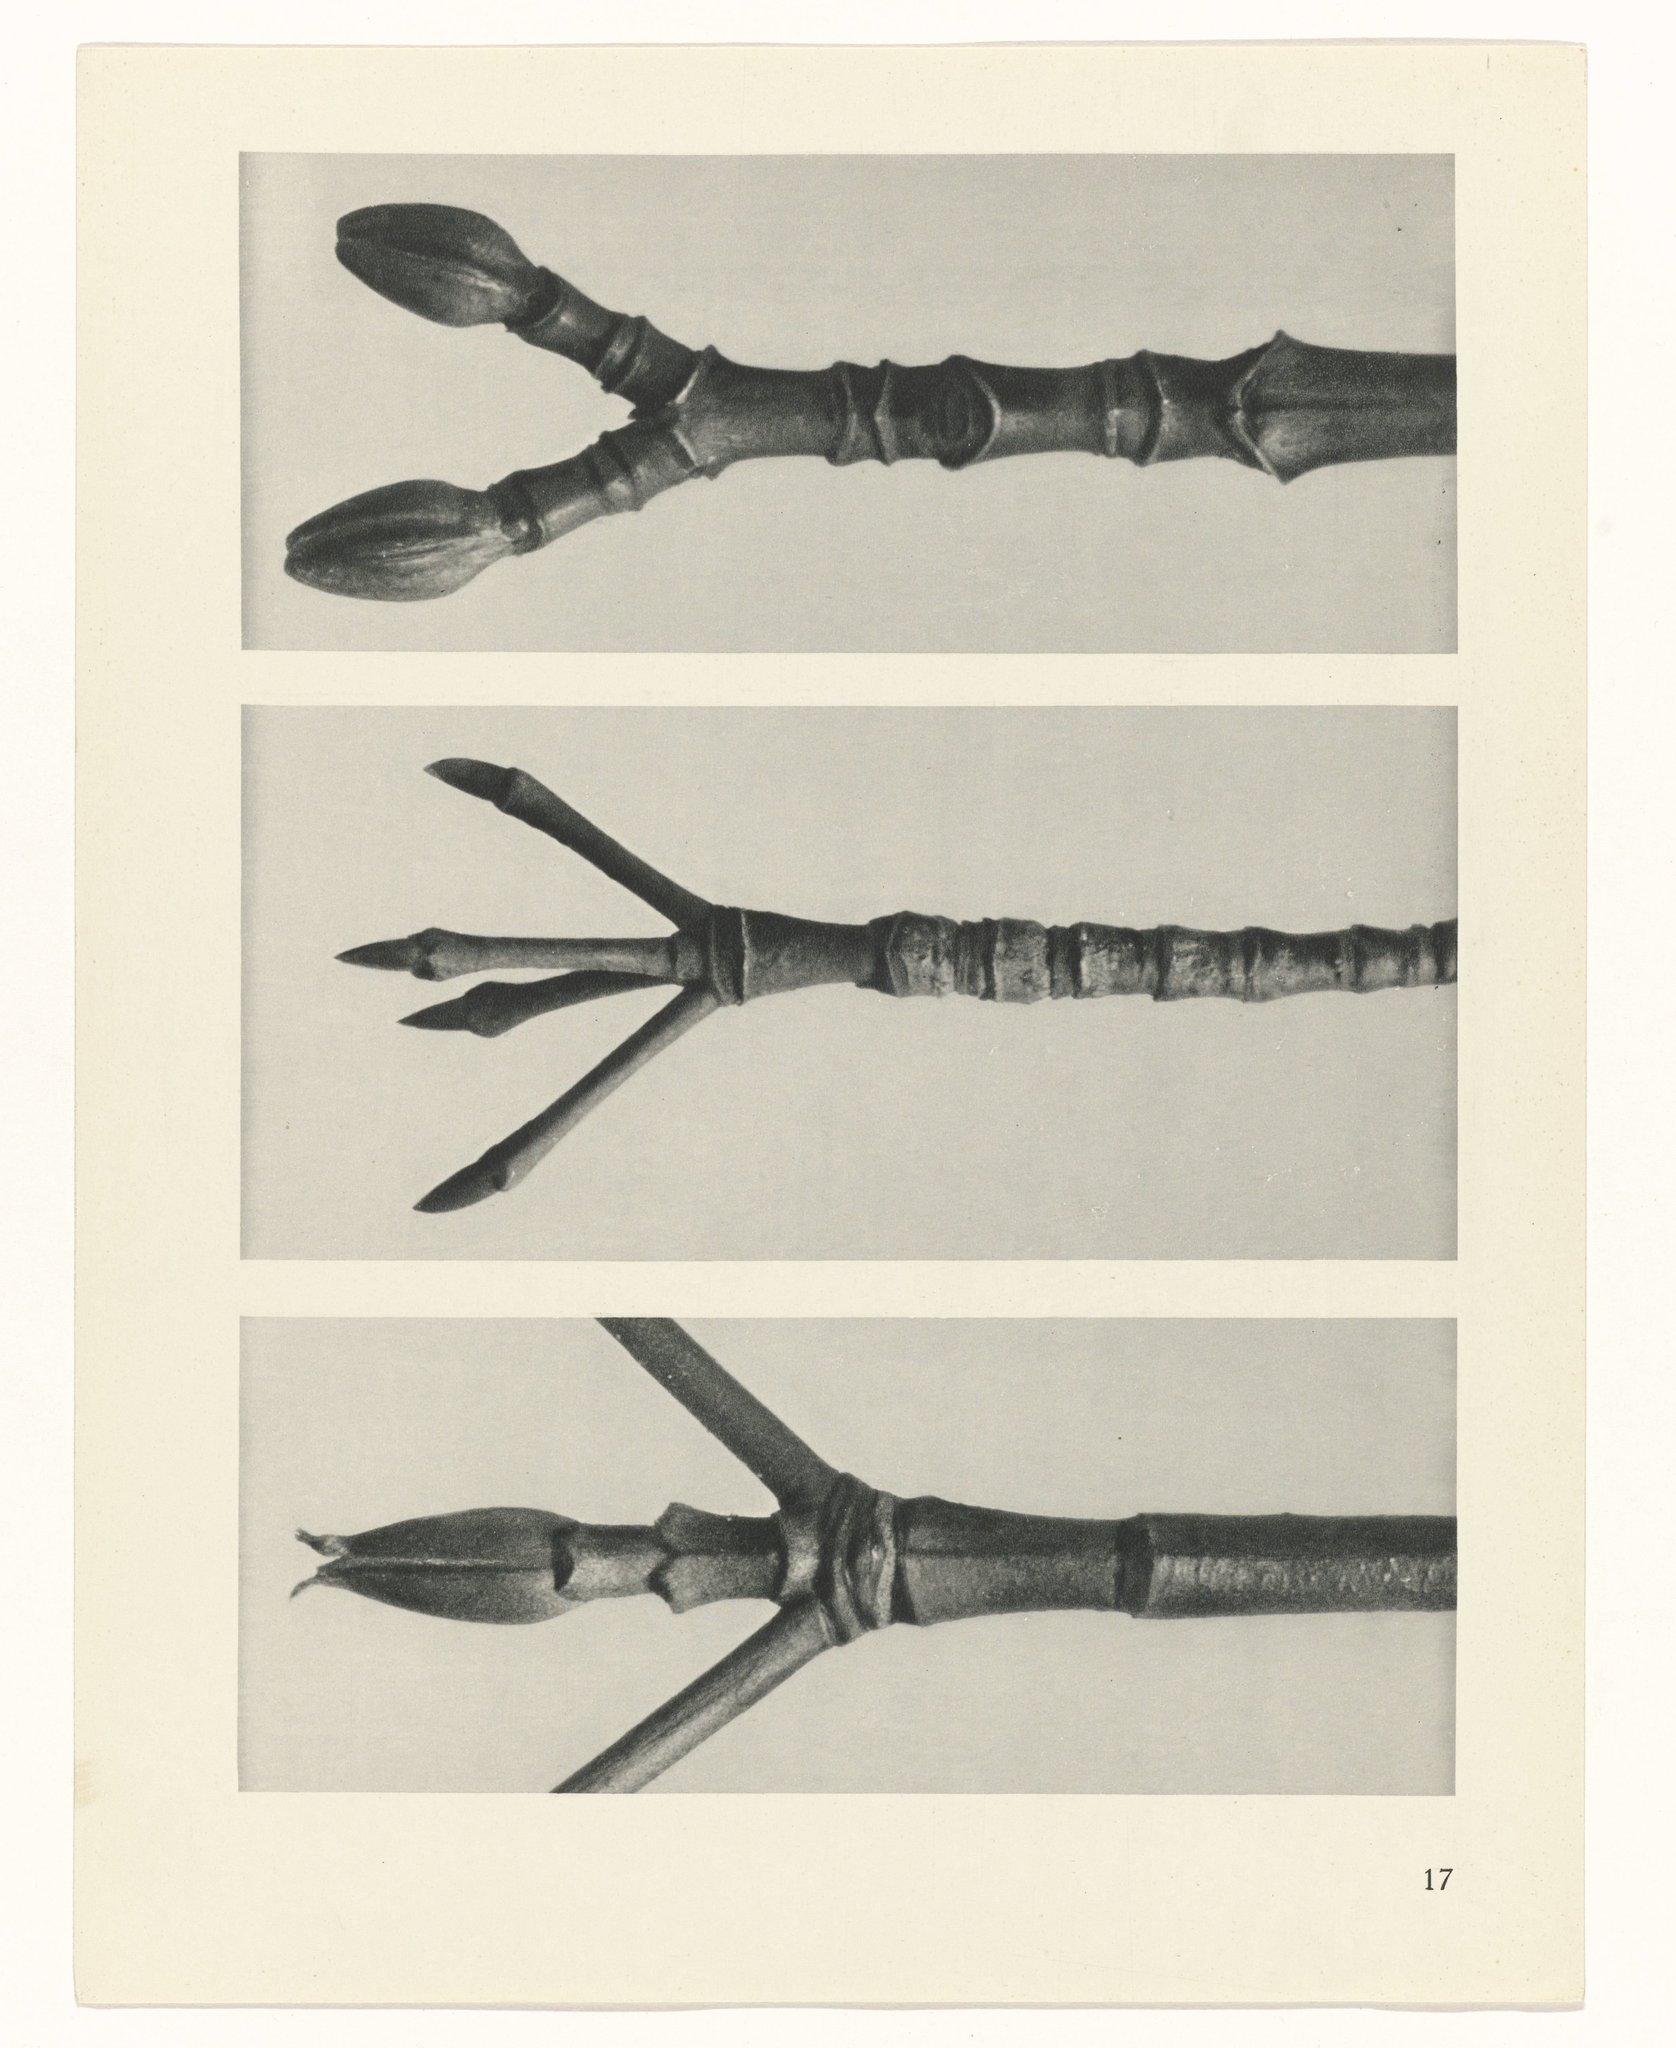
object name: photograph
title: Urformen der Kunst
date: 1928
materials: ink, paper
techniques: rotogravure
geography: berlin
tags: plants (in general)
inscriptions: number: ‘17’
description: facher Vergrößerung. Afkomstig uit losbladige uitgave.